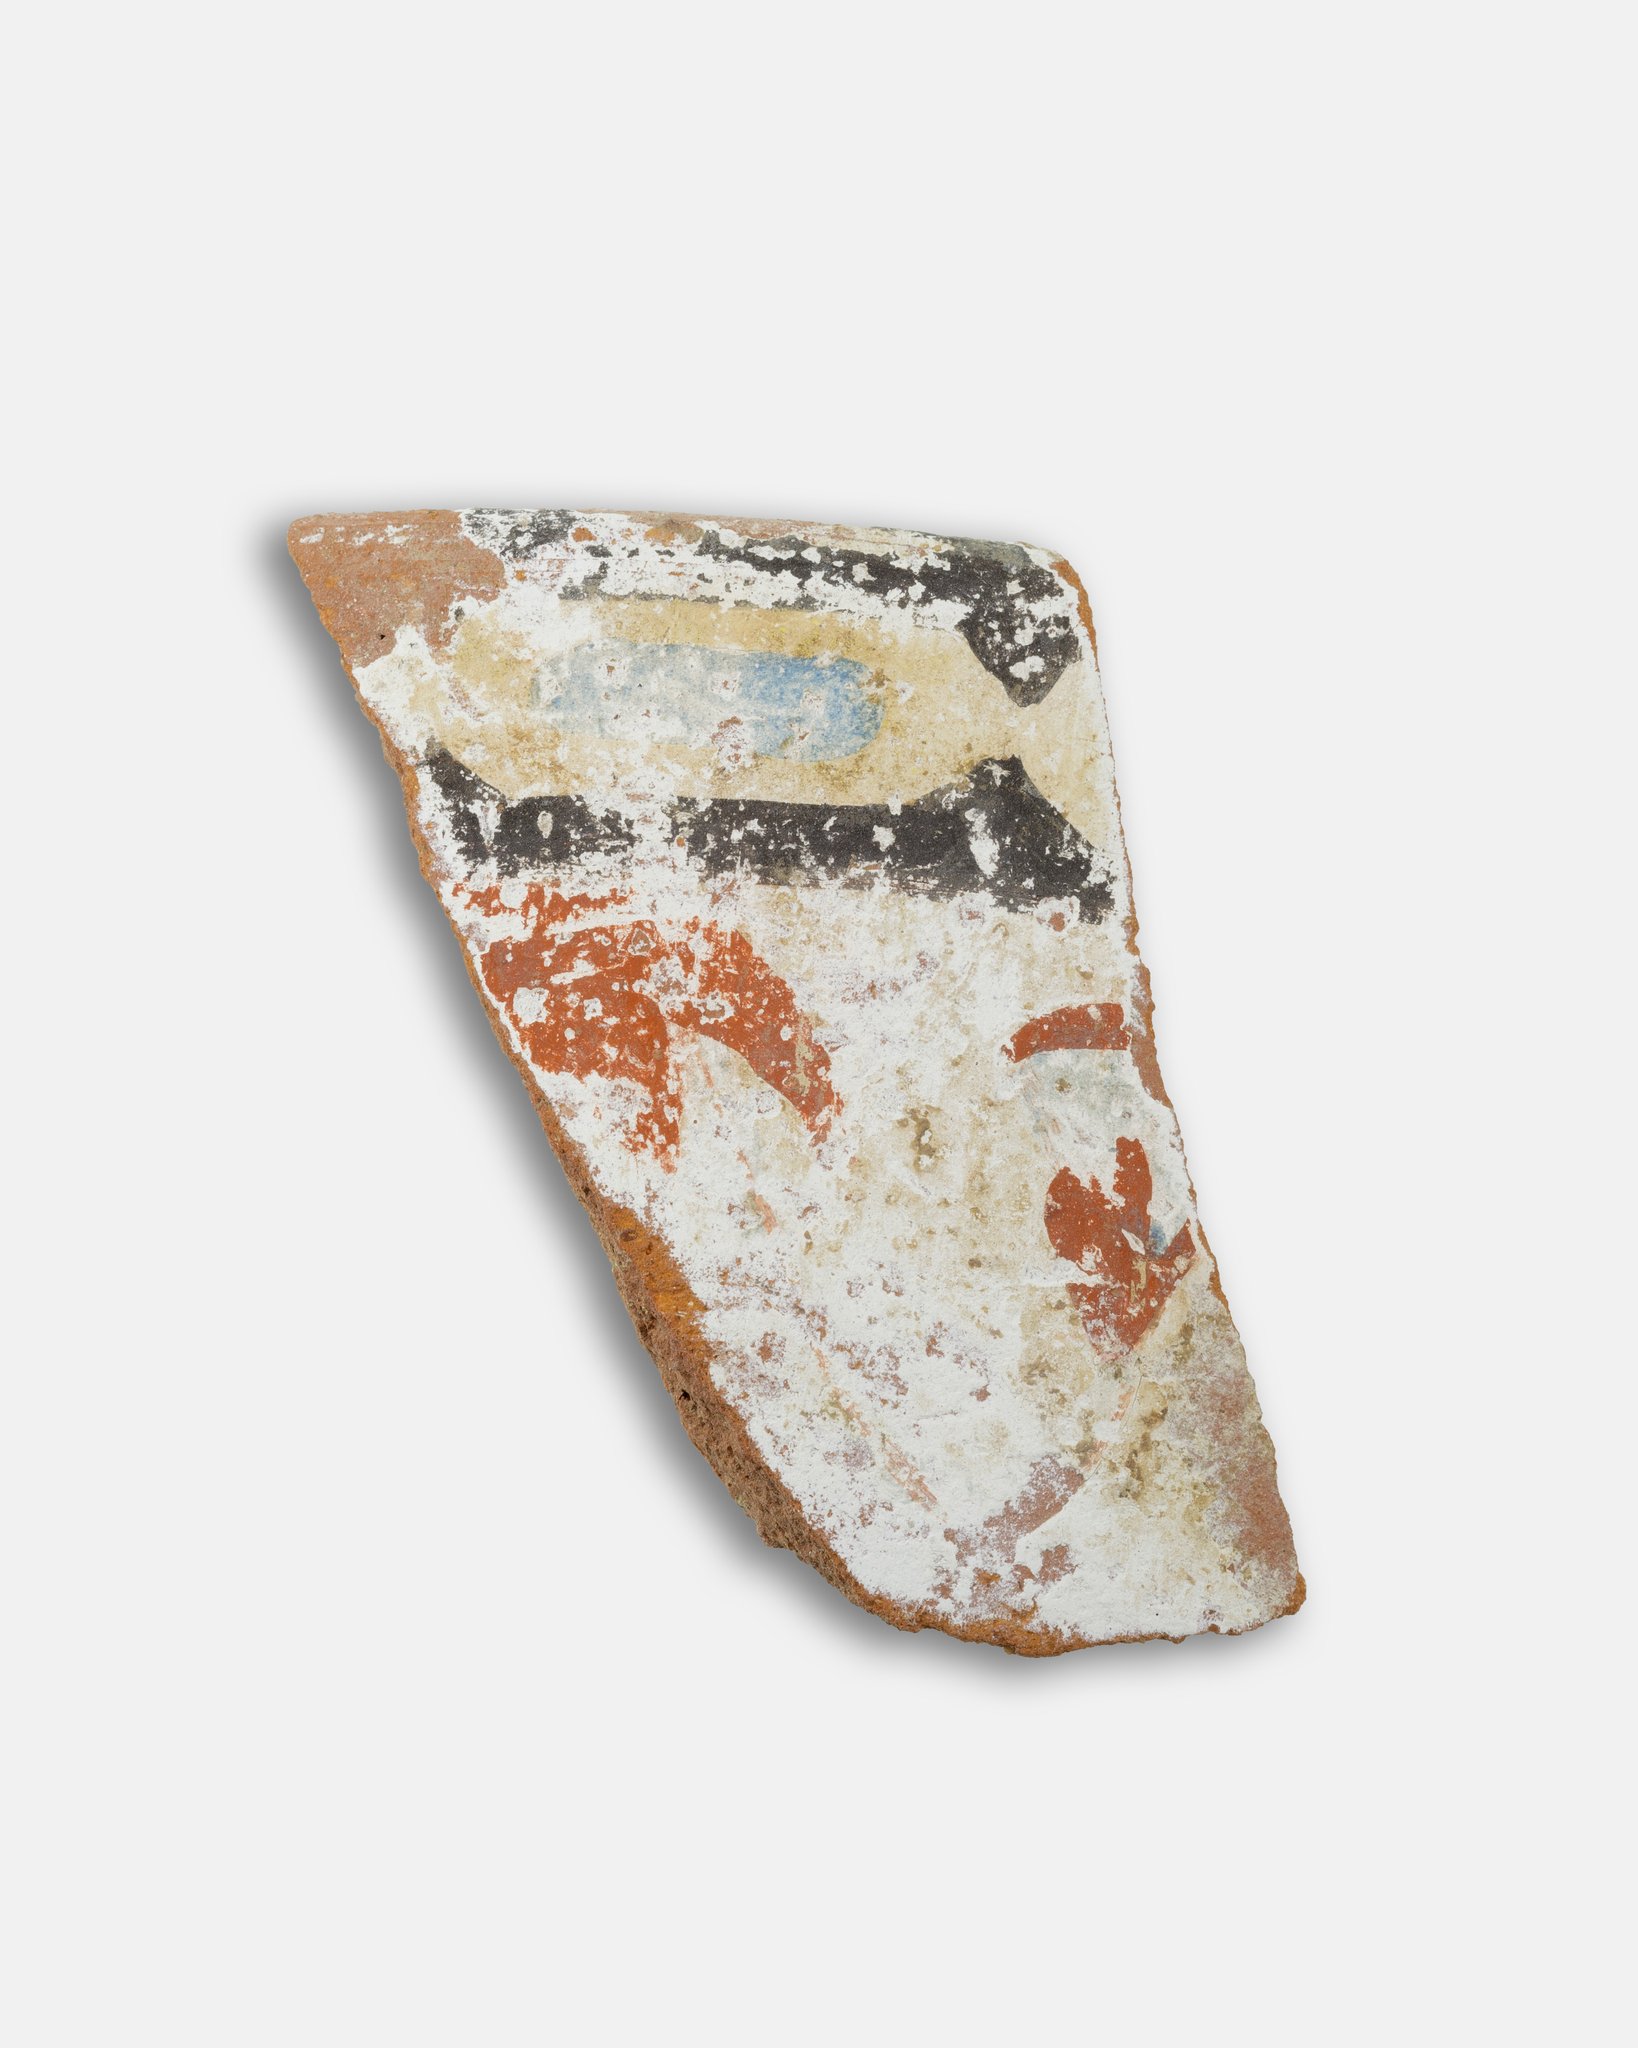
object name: jar fragment, inscribed, malqata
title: Decorated jar fragment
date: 1390-1352 BCE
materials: ink, paint, pottery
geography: egypt